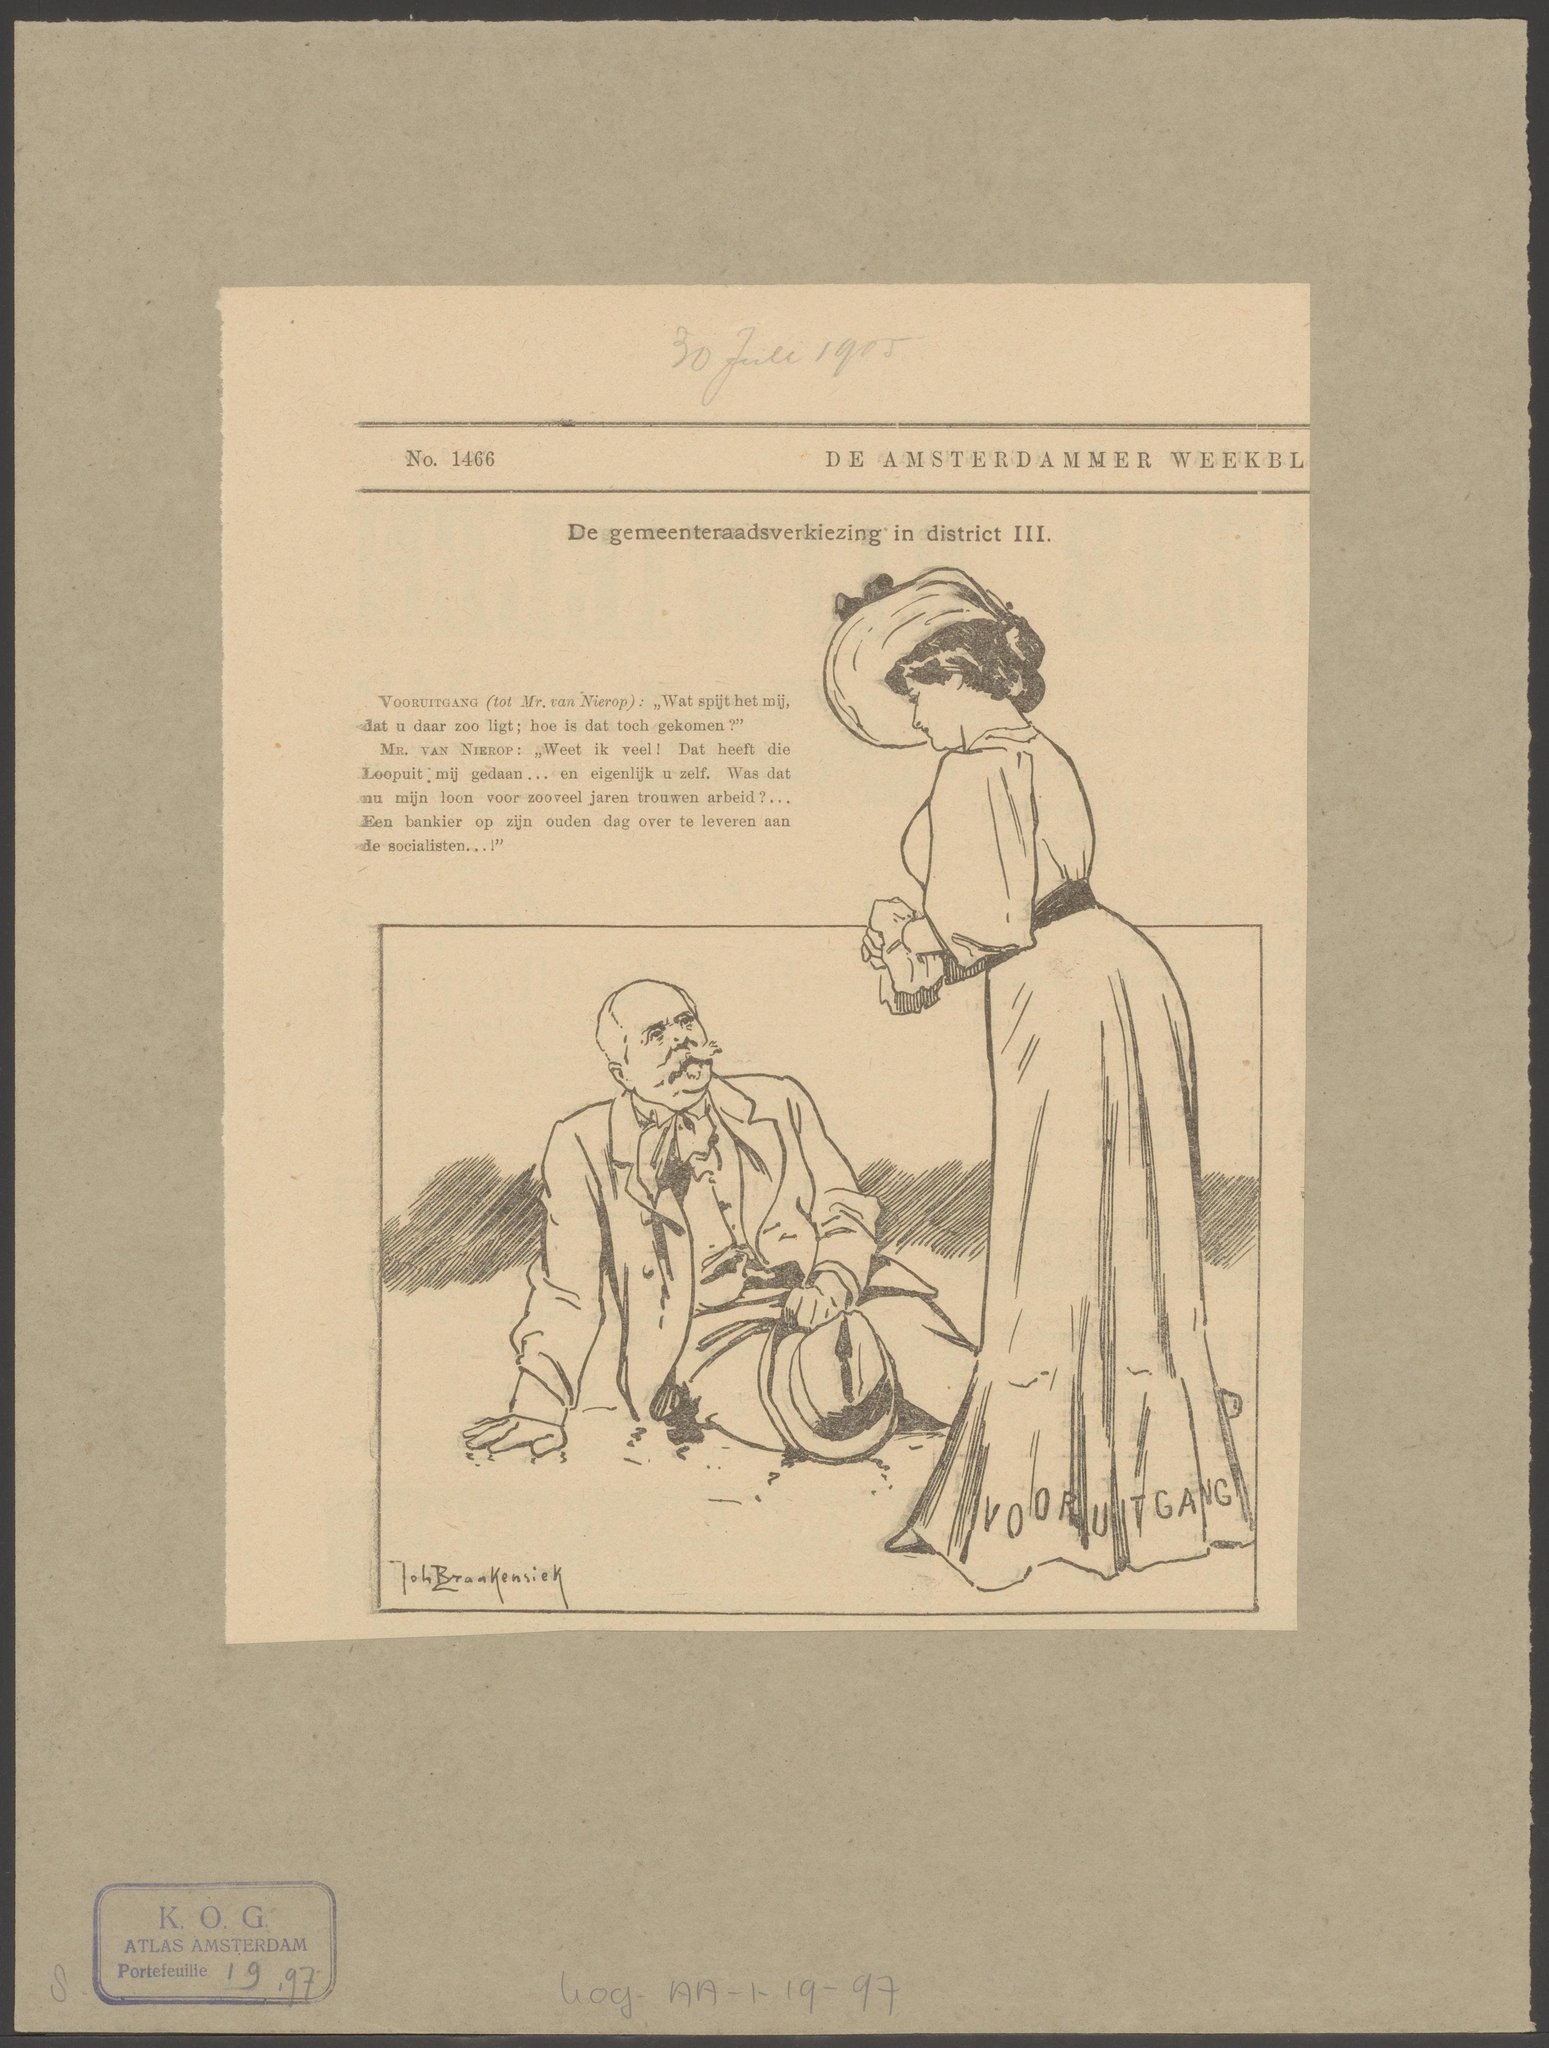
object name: cartoon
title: Spotprent op Frederik Salomon van Nierop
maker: johan braakensiek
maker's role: draughtsman, print maker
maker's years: 1858-1940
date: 1905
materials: paper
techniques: letterpress printing, line block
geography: amsterdam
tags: amsterdam, politician, e.g. party leader, political caricatures and satires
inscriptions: collector's mark: ‘19,97’ Lugt 1641b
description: Onderwerpsrubriek binnen de Atlas Amsterdam: Herinneringen aan regeringsleden en hunne huisgezinnen [na 1800].